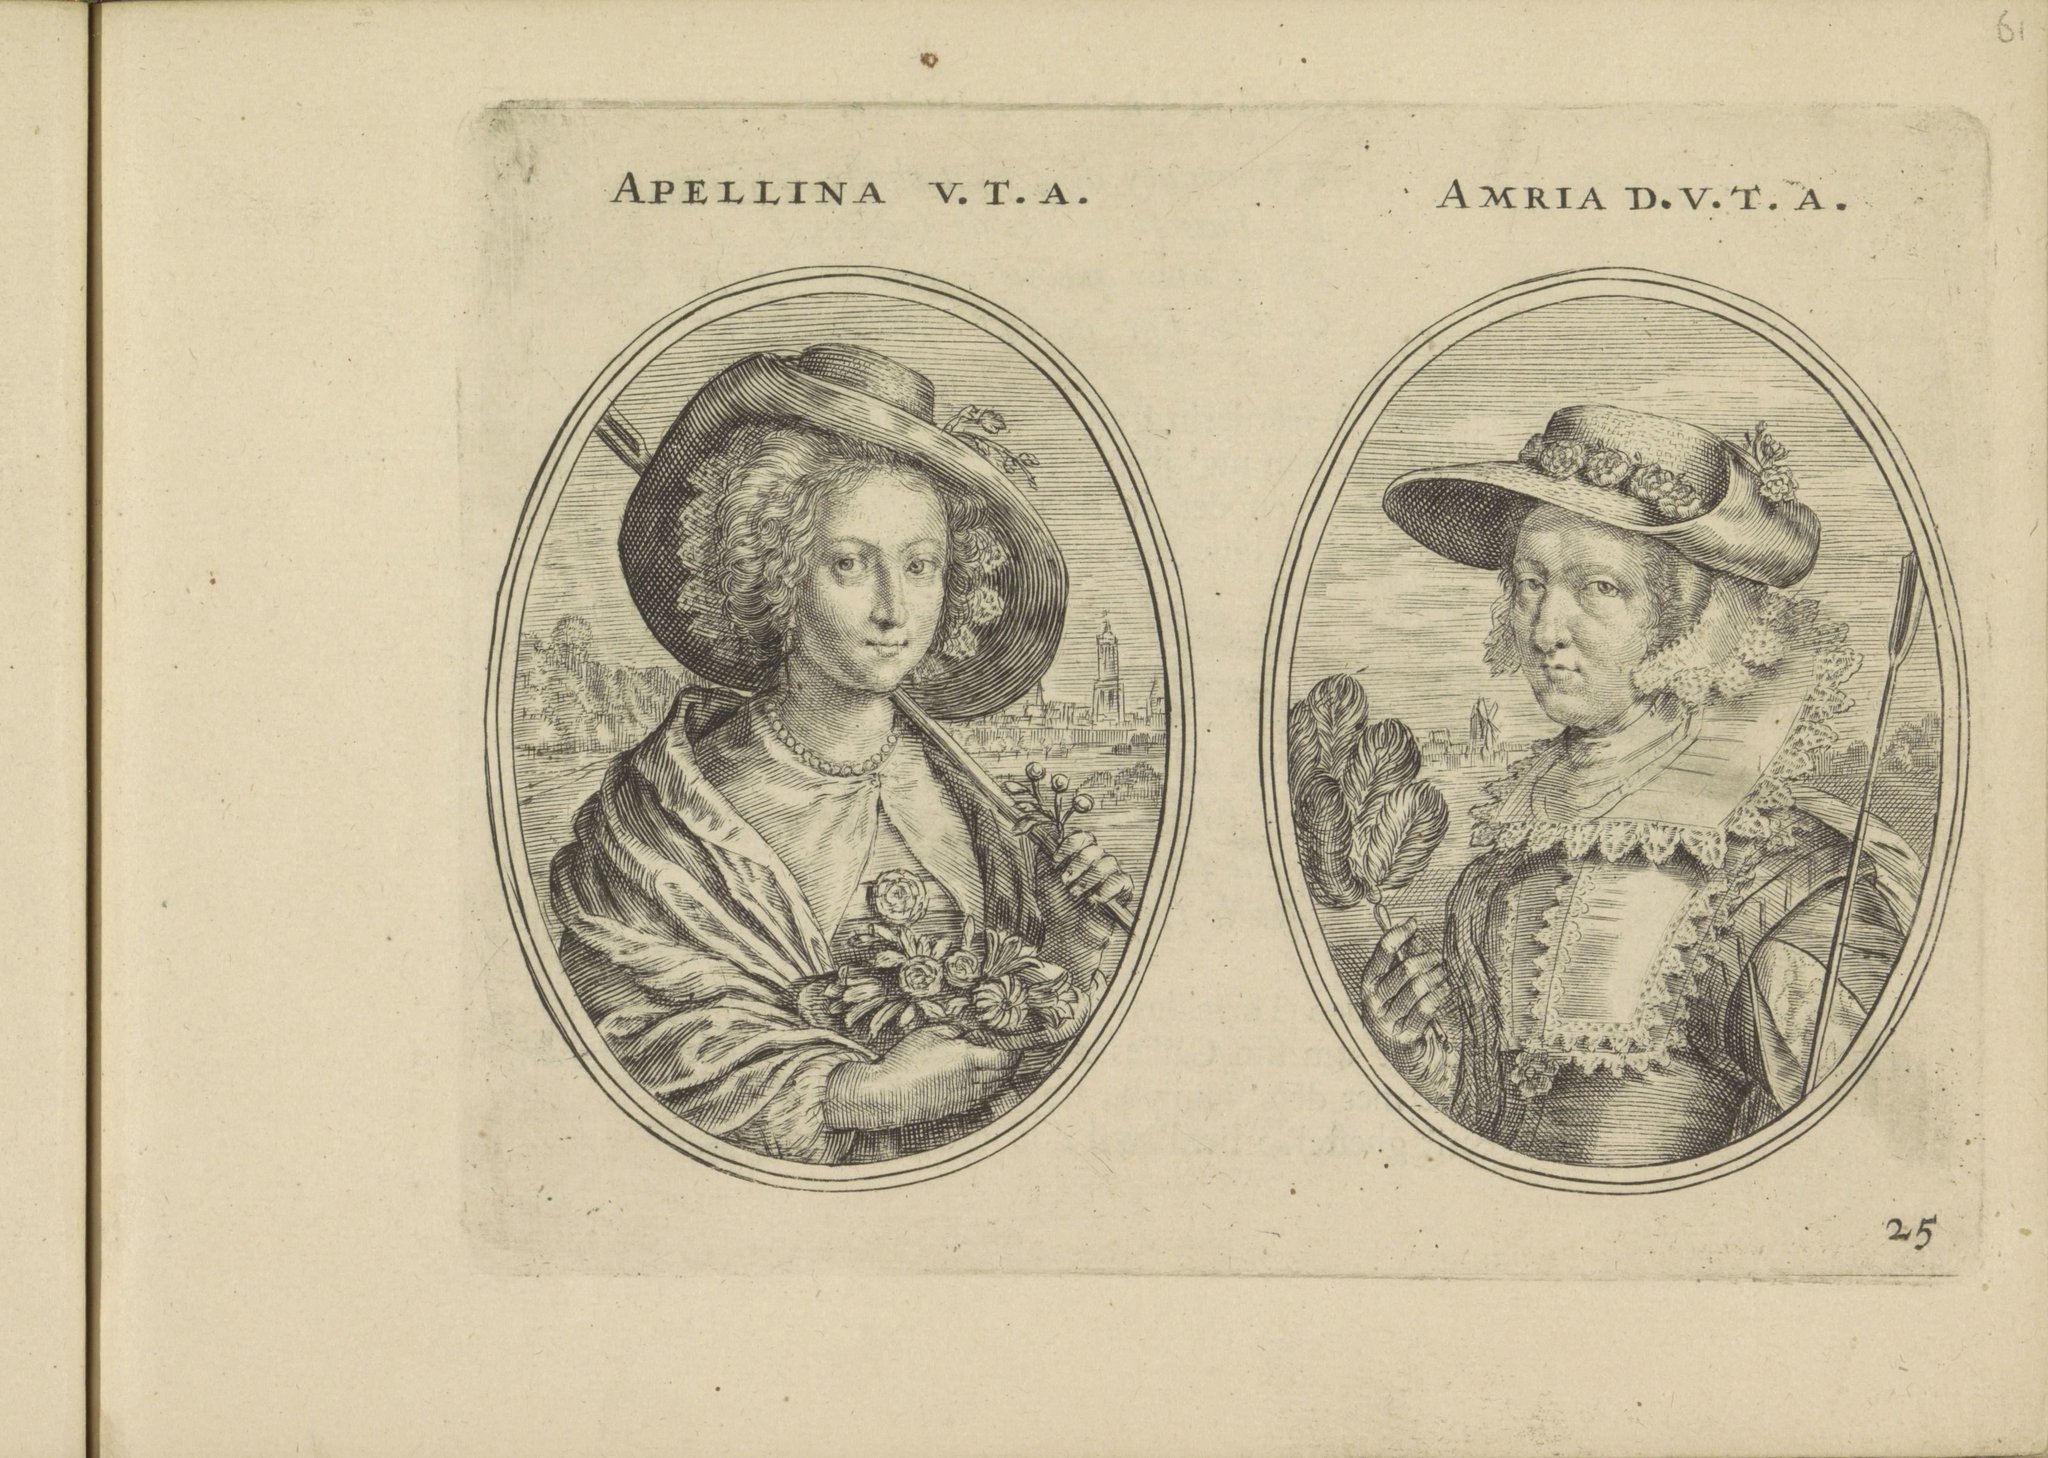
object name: album leaf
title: Portretten van Magdalena van de Passe en een onbekende vrouw, beiden als herderin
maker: crispijn van de passe (ii)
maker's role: draughtsman, print maker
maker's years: 1594-1670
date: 1640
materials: paper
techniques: engraving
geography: amsterdam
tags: cologne, utrecht, print maker, magdalena van de passe, female sex; woman, shepherd's crook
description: Twee voorstellingen op een albumblad. Links het portret van Magdalena van de Passe als Apellina V.T.A. Rechts een onbekende vrouw als Amria D.V.T.A. De vrouwen hebben een herdersstaf in de hand. Op de achtergrond respectievelijk een stadsgezicht (de Domtoren?) en een molen. Onderaan genummerd: 25. Het blad maakt deel uit van een album.